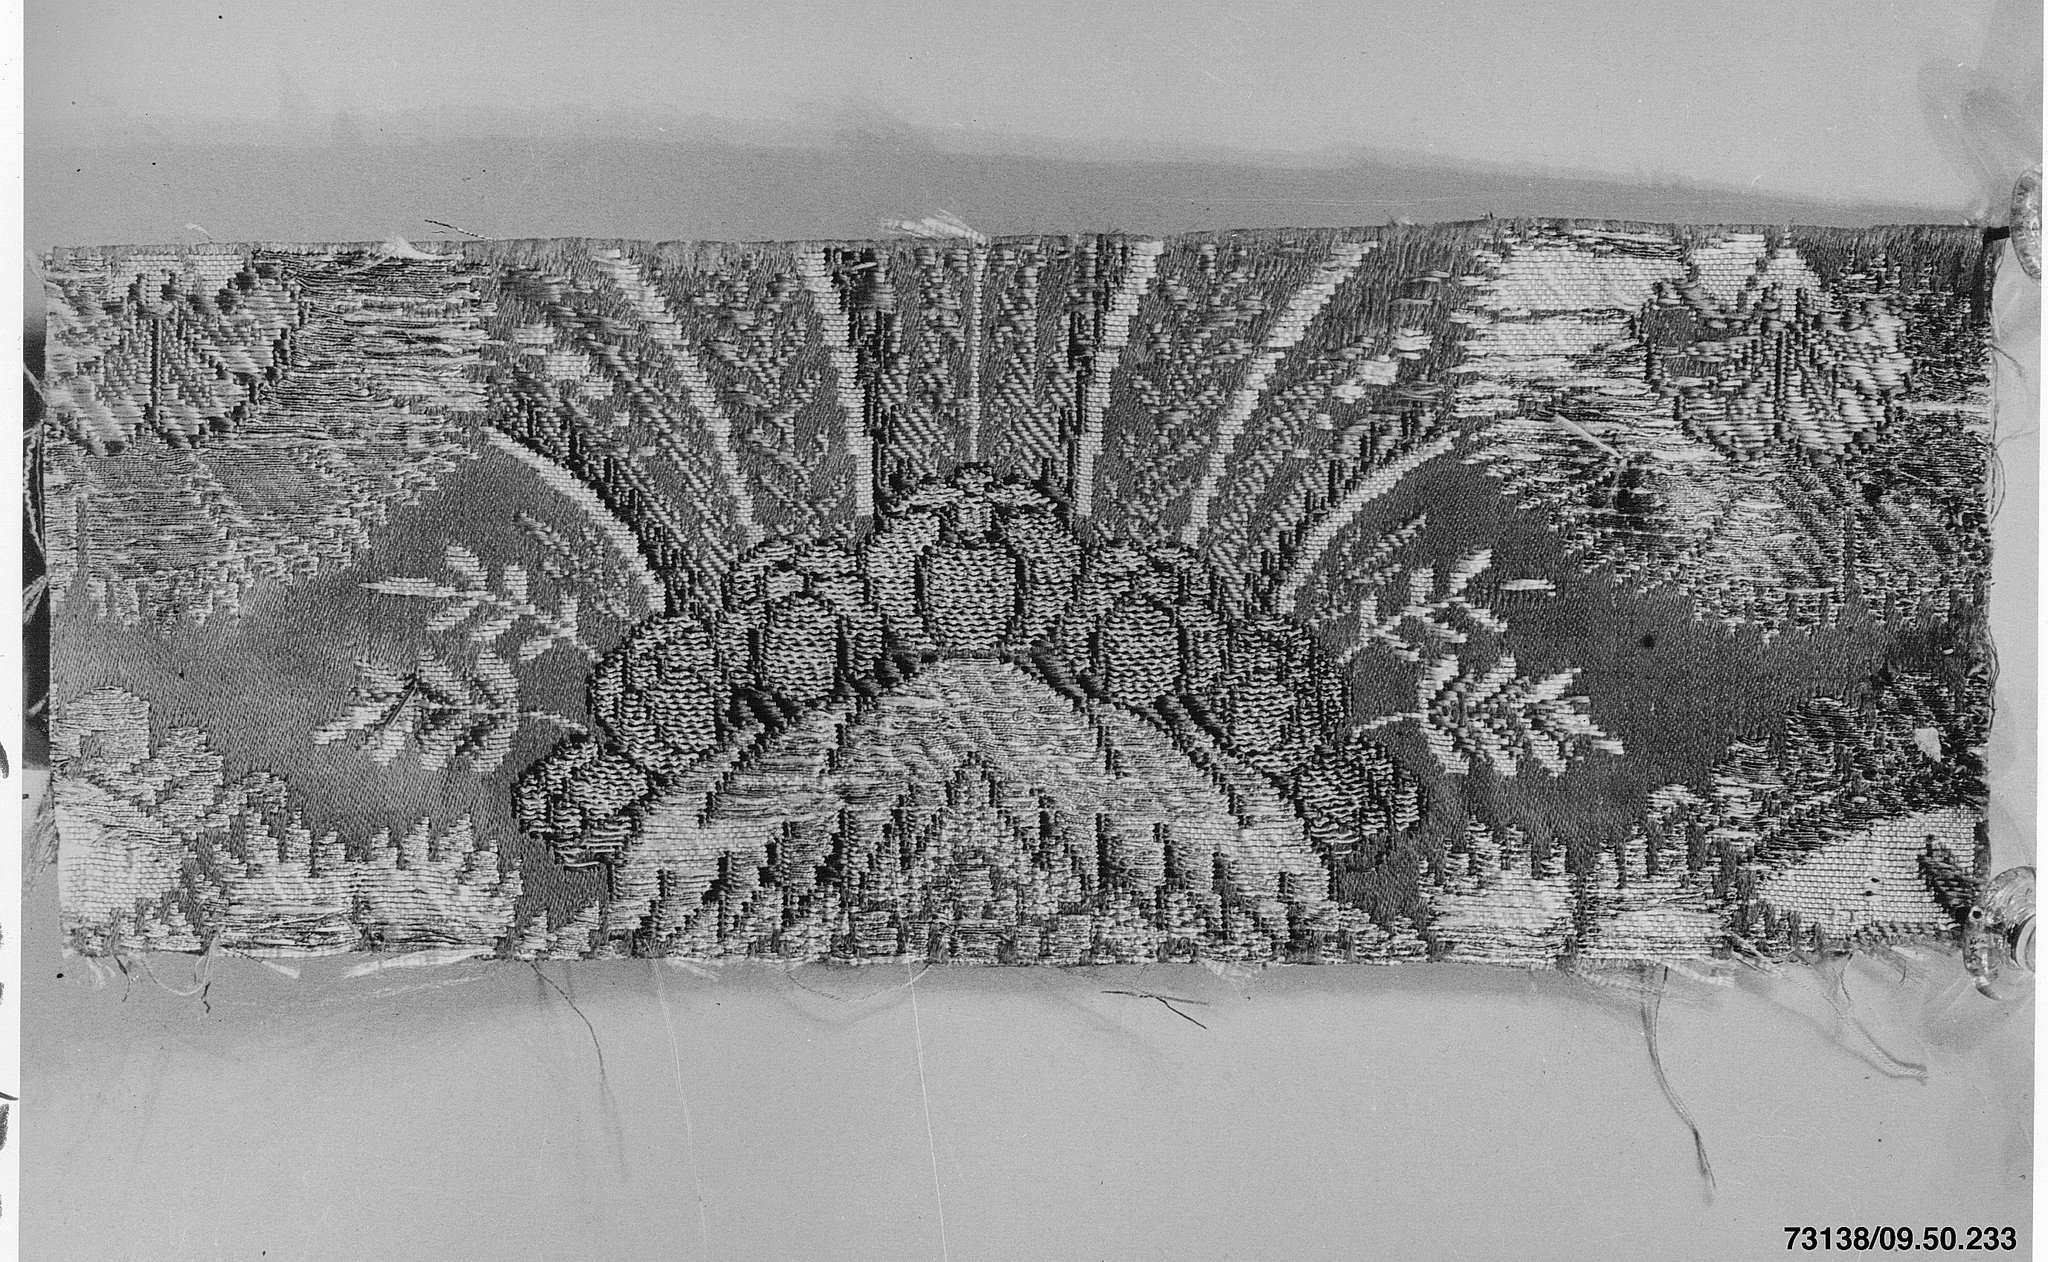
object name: piece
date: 1720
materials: metal thread, silk